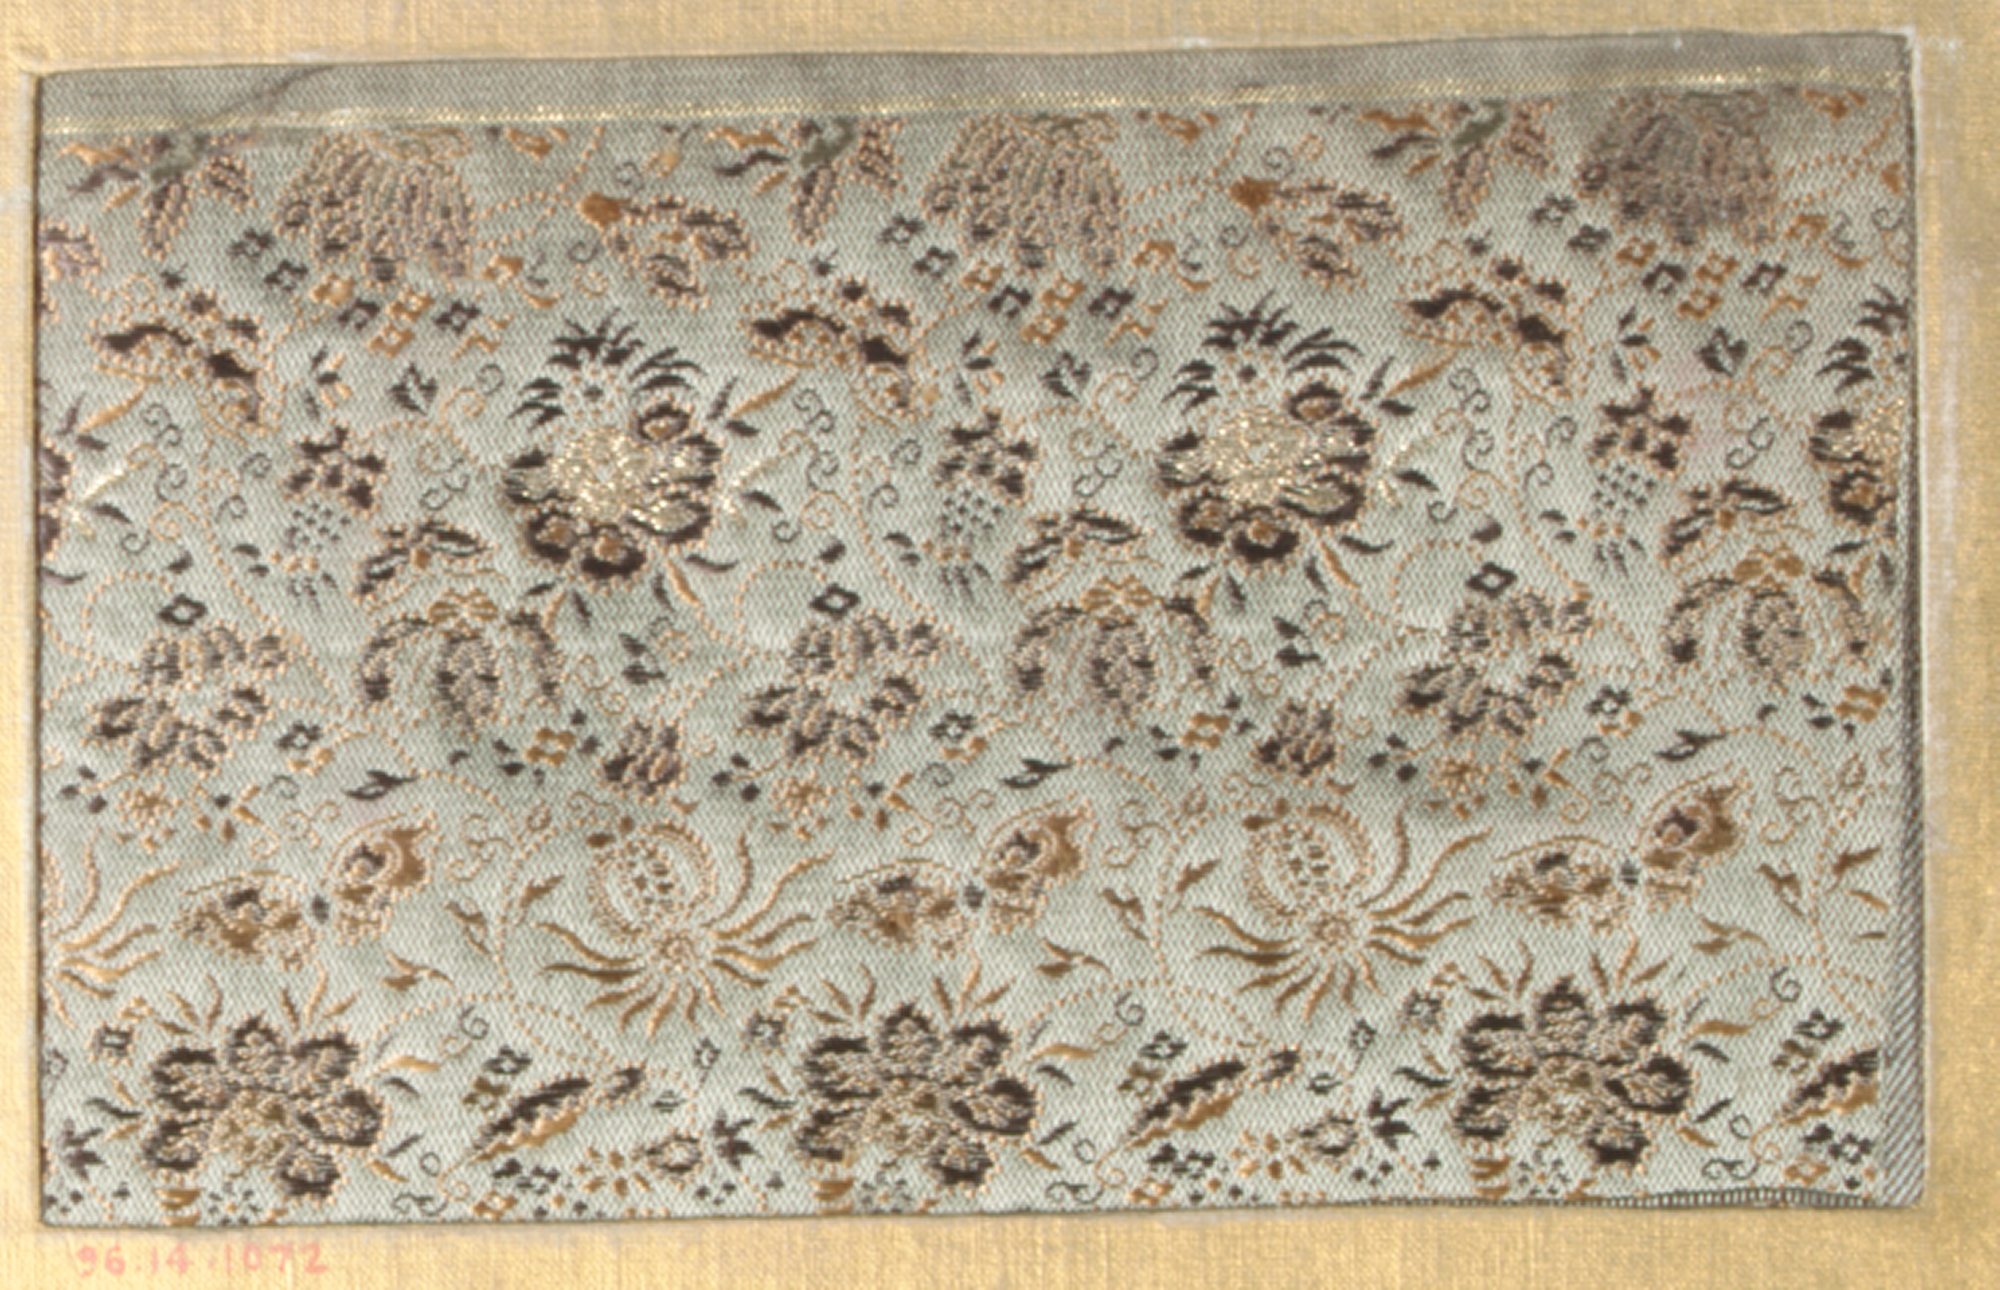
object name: piece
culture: japanese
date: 1701-1900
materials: silk